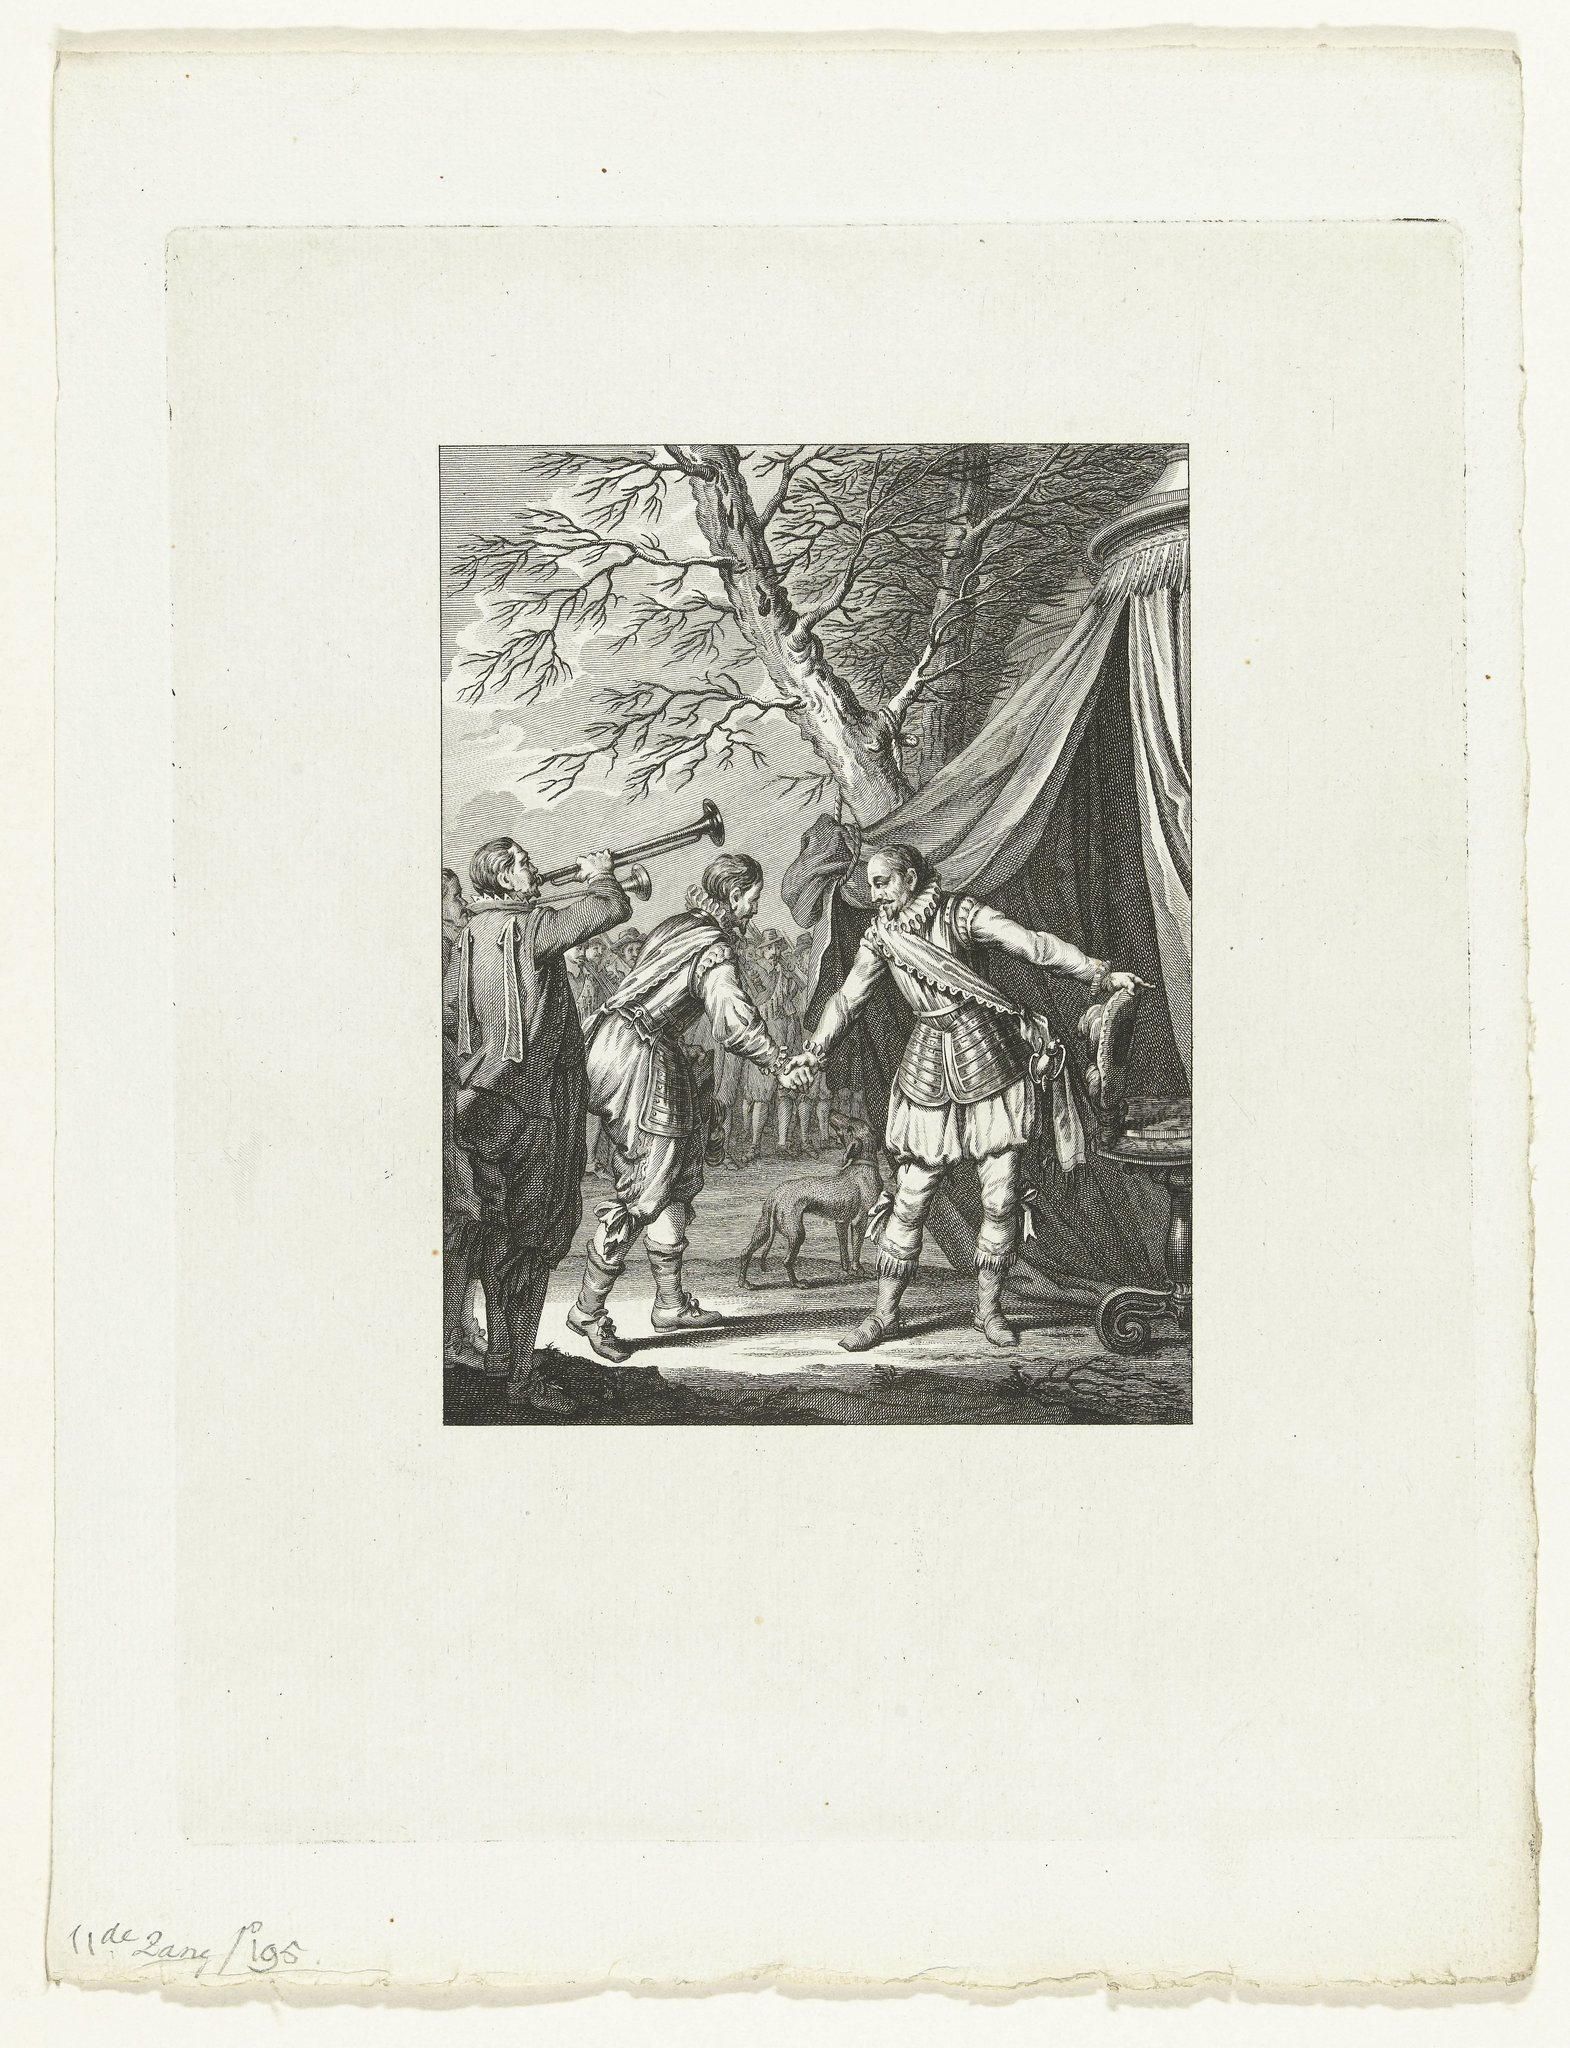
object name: print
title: Ontmoeting tussch. Willem en Mondragon / XI. zang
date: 1781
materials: paper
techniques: etching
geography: amsterdam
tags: middelburg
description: Illustratie voor: J. Nomsz, Willem de eerste, of de grondlegging der Nederlandsche vryheid. : In vier en twintig zangen, Erven van David Klippink, Amsterdam 1779. Staat vóór de letter. Groep van vier proefdrukken in de oorspronkelijke omslag van de uitgevers J. Smit en Zoon en W. Vermandel te Amsterdam, 1781 (de derde uitgave).